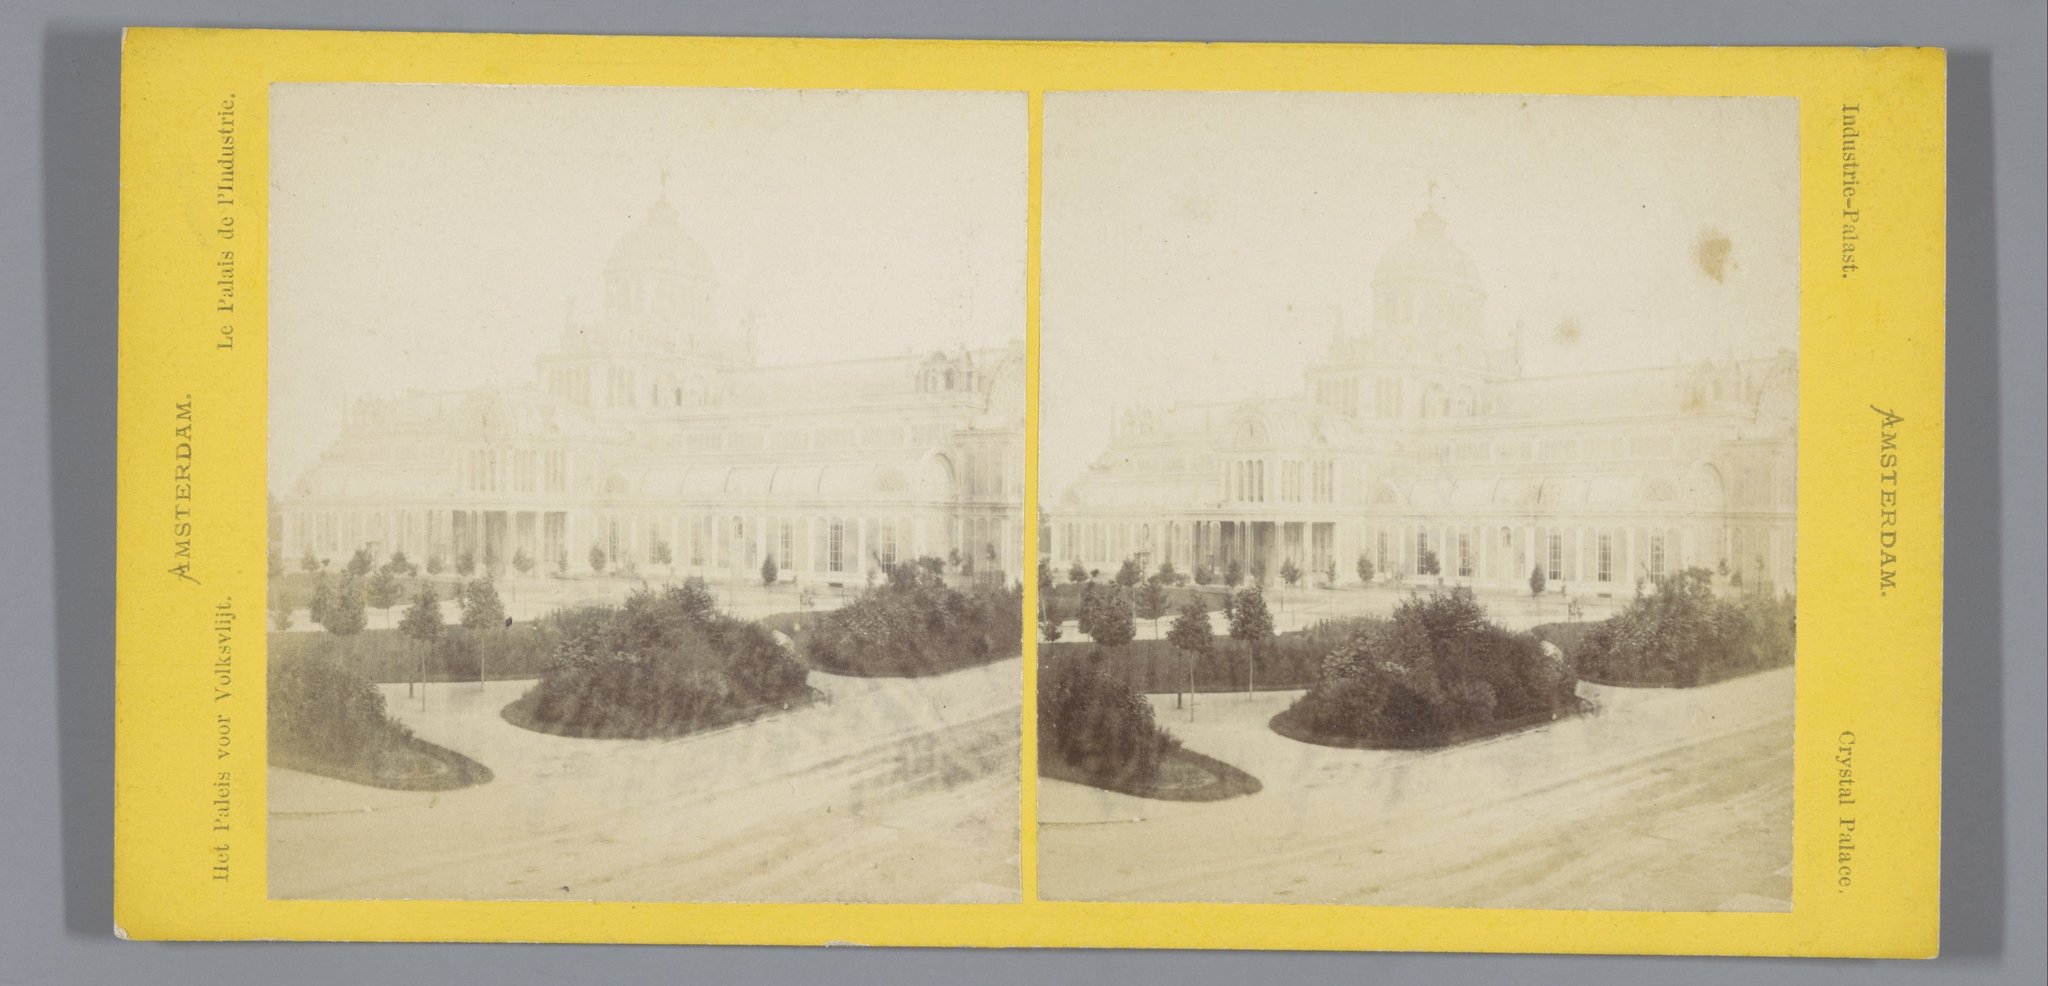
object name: stereograph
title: Het Paleis voor Volksvlijt; Le Palais de l'Industrie; Crystal Palace; Industrie Palast.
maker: Anonymous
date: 1864-1870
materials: cardboard, paper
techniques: albumen print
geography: amsterdam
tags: edifice, e.g.: public building, department store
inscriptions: inscription: ‘C W van tante en Oom Meder [?]’